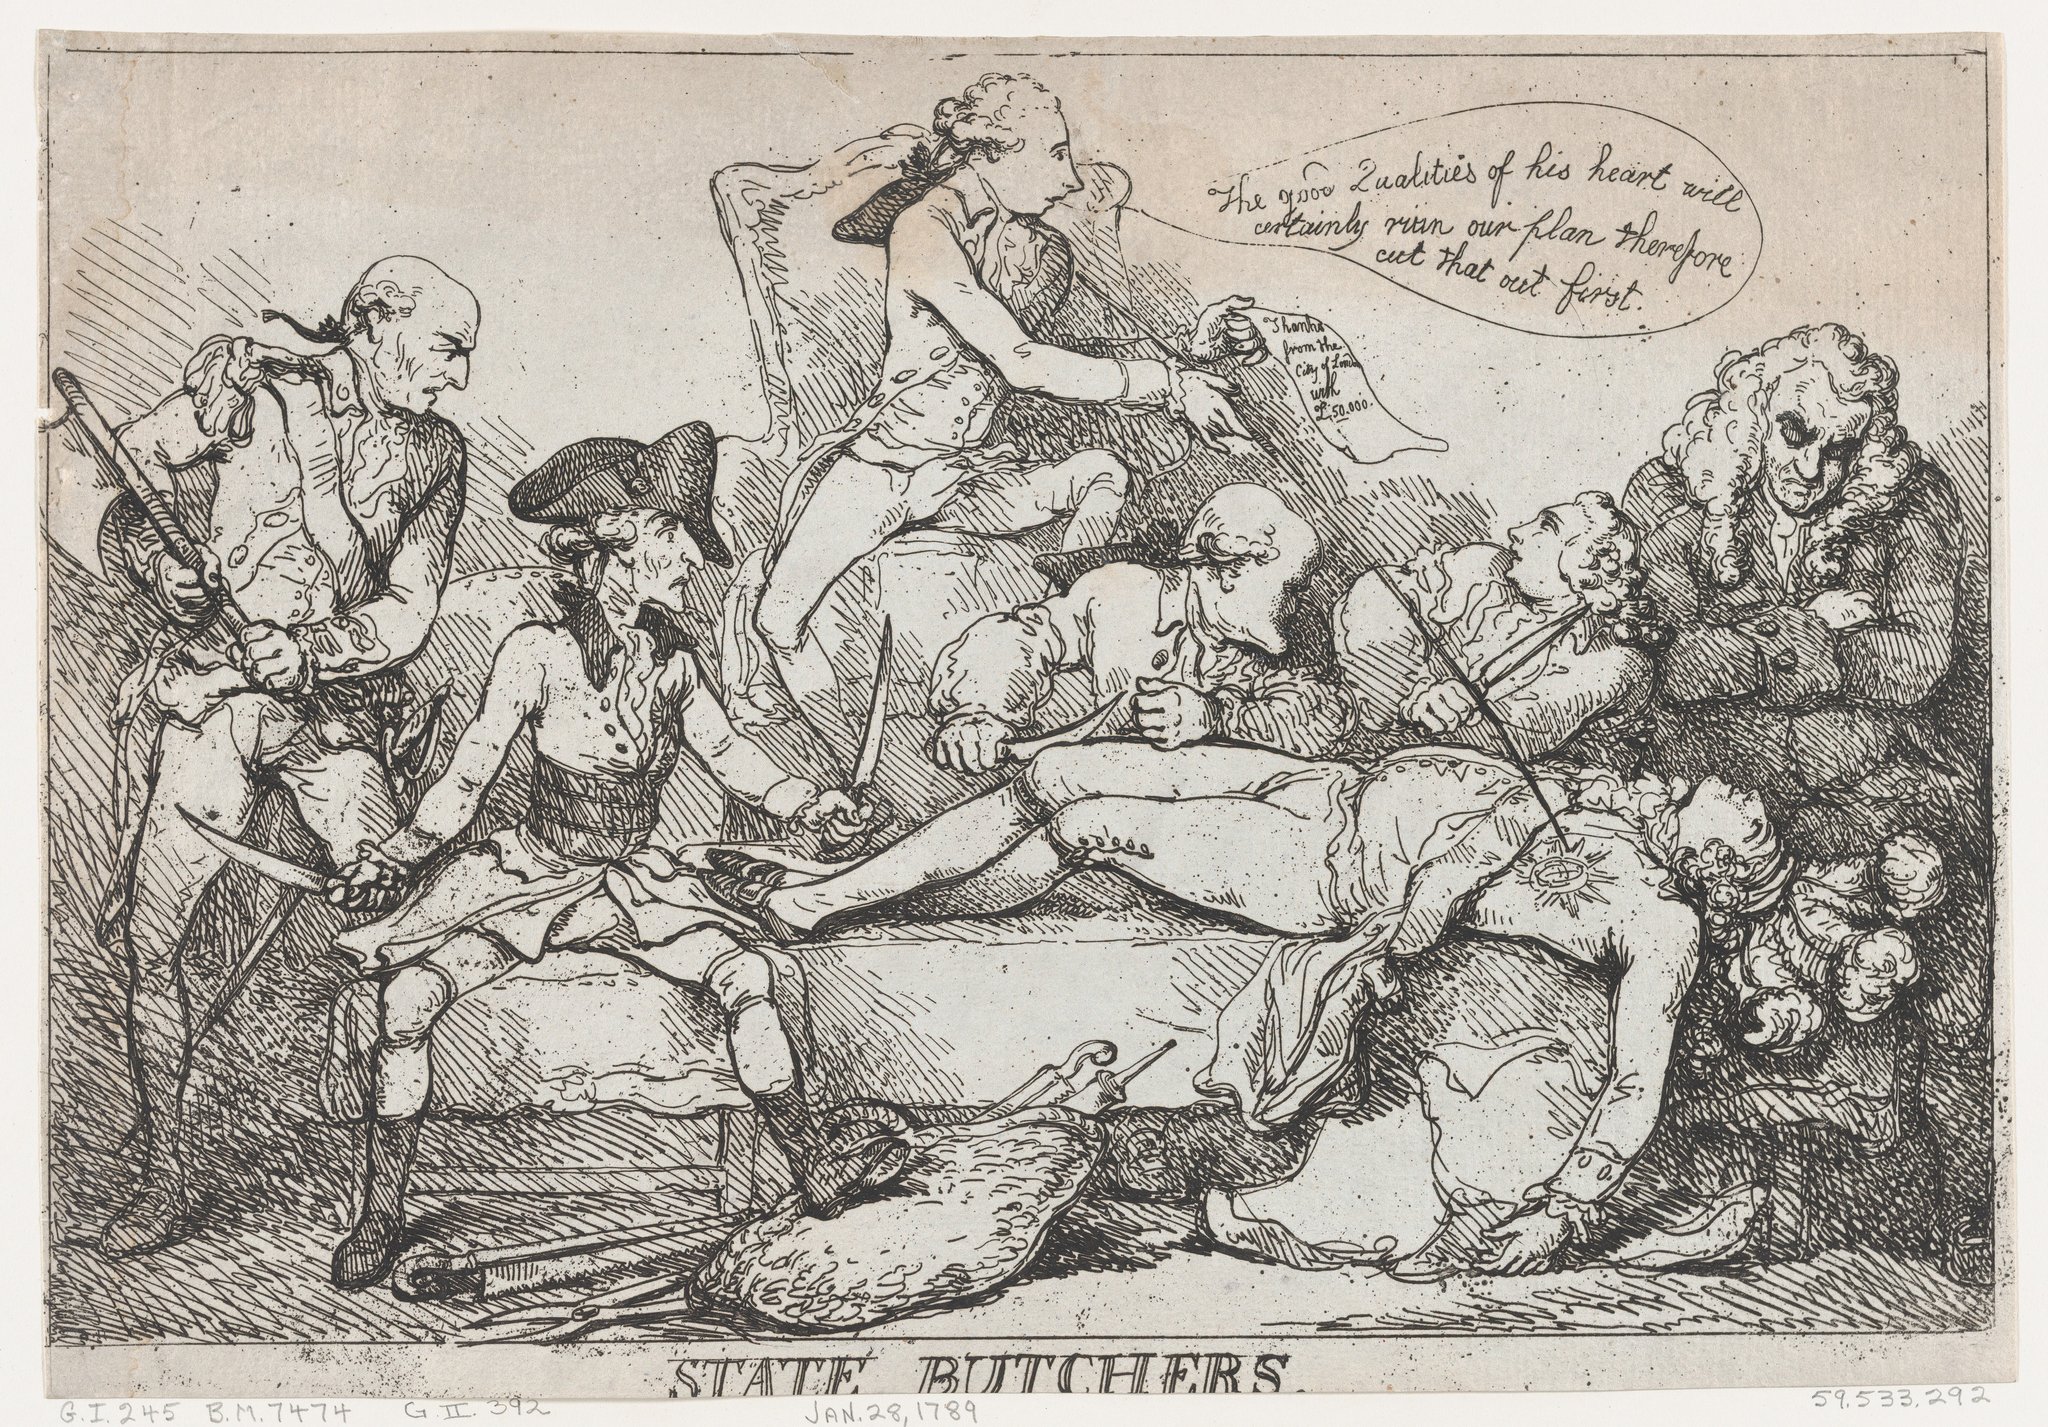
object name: print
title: State Butchers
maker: thomas rowlandson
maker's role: artist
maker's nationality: british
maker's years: 1757-1827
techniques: etching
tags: satire,men,death